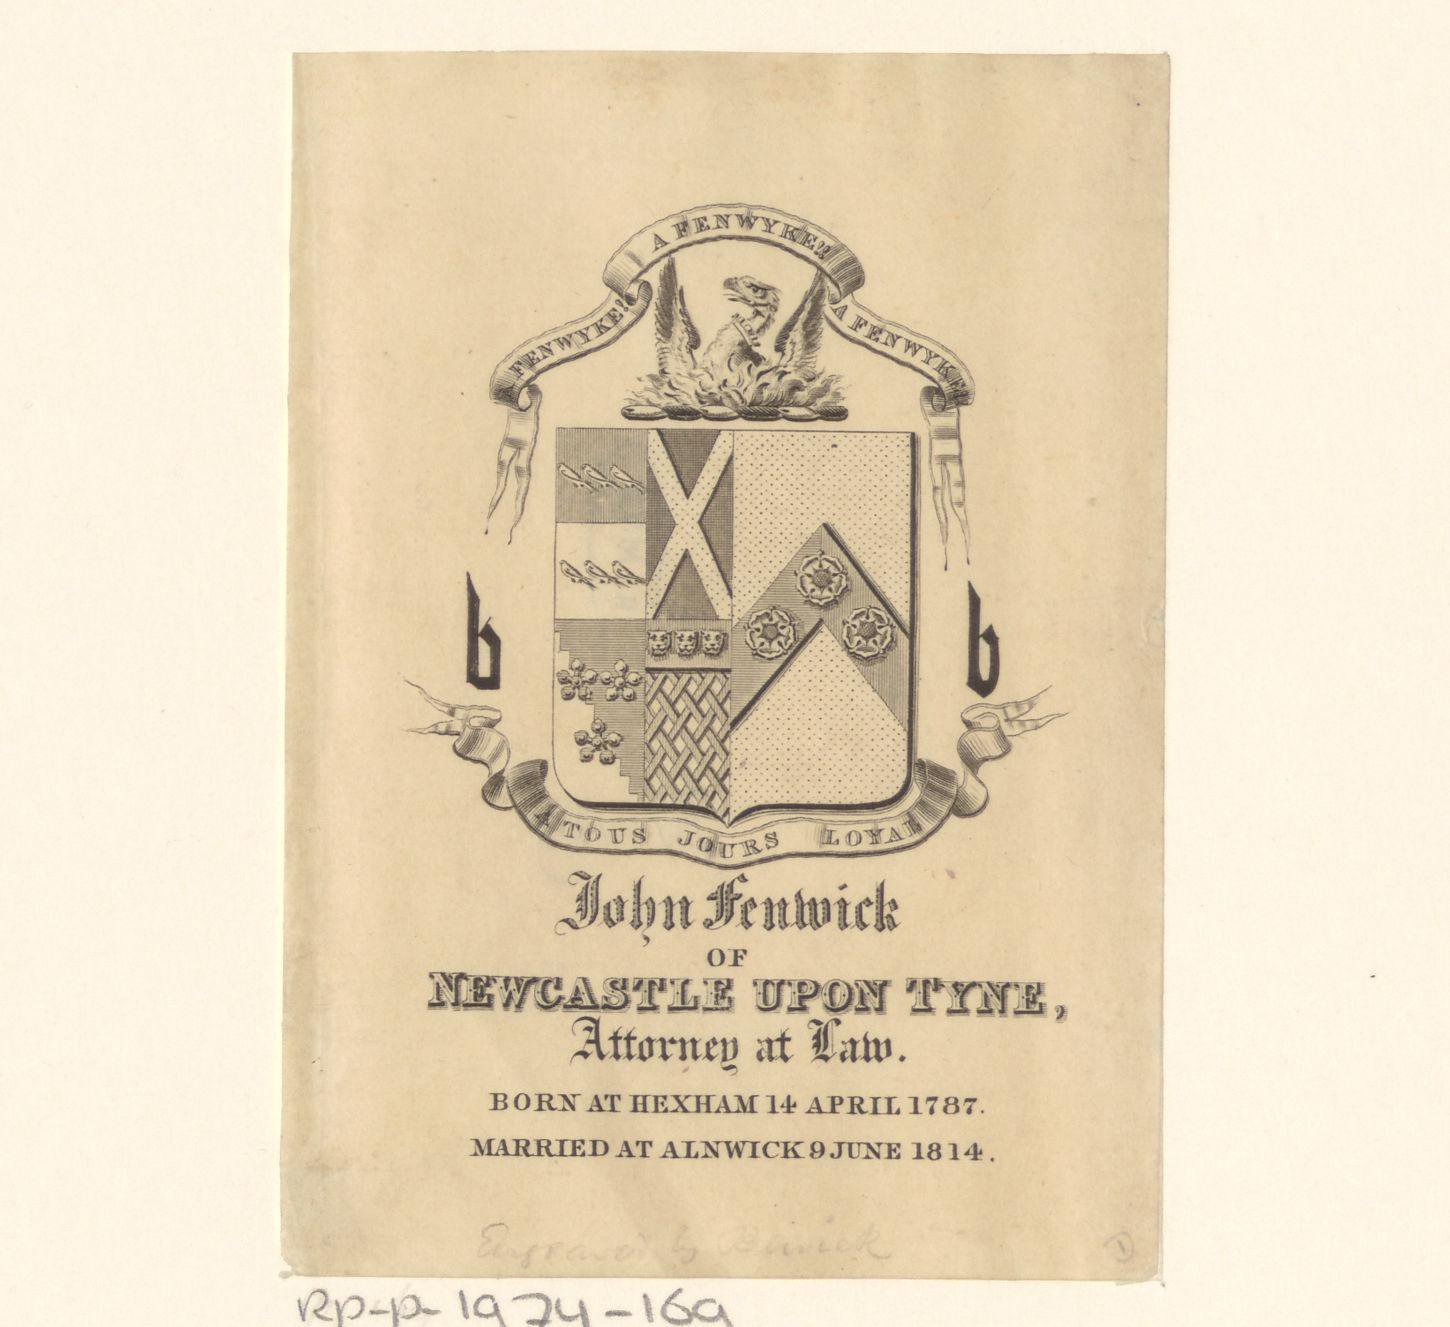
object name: bookplate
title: A tous jours loyal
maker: thomas bewick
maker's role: draughtsman, painter, print maker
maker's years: 1753-1828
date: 1814-1828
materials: paper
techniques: engraving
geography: great britain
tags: fabulous animals ~ birds: phoenix, armorial bearing, heraldry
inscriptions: collector's mark: Lugt 2228